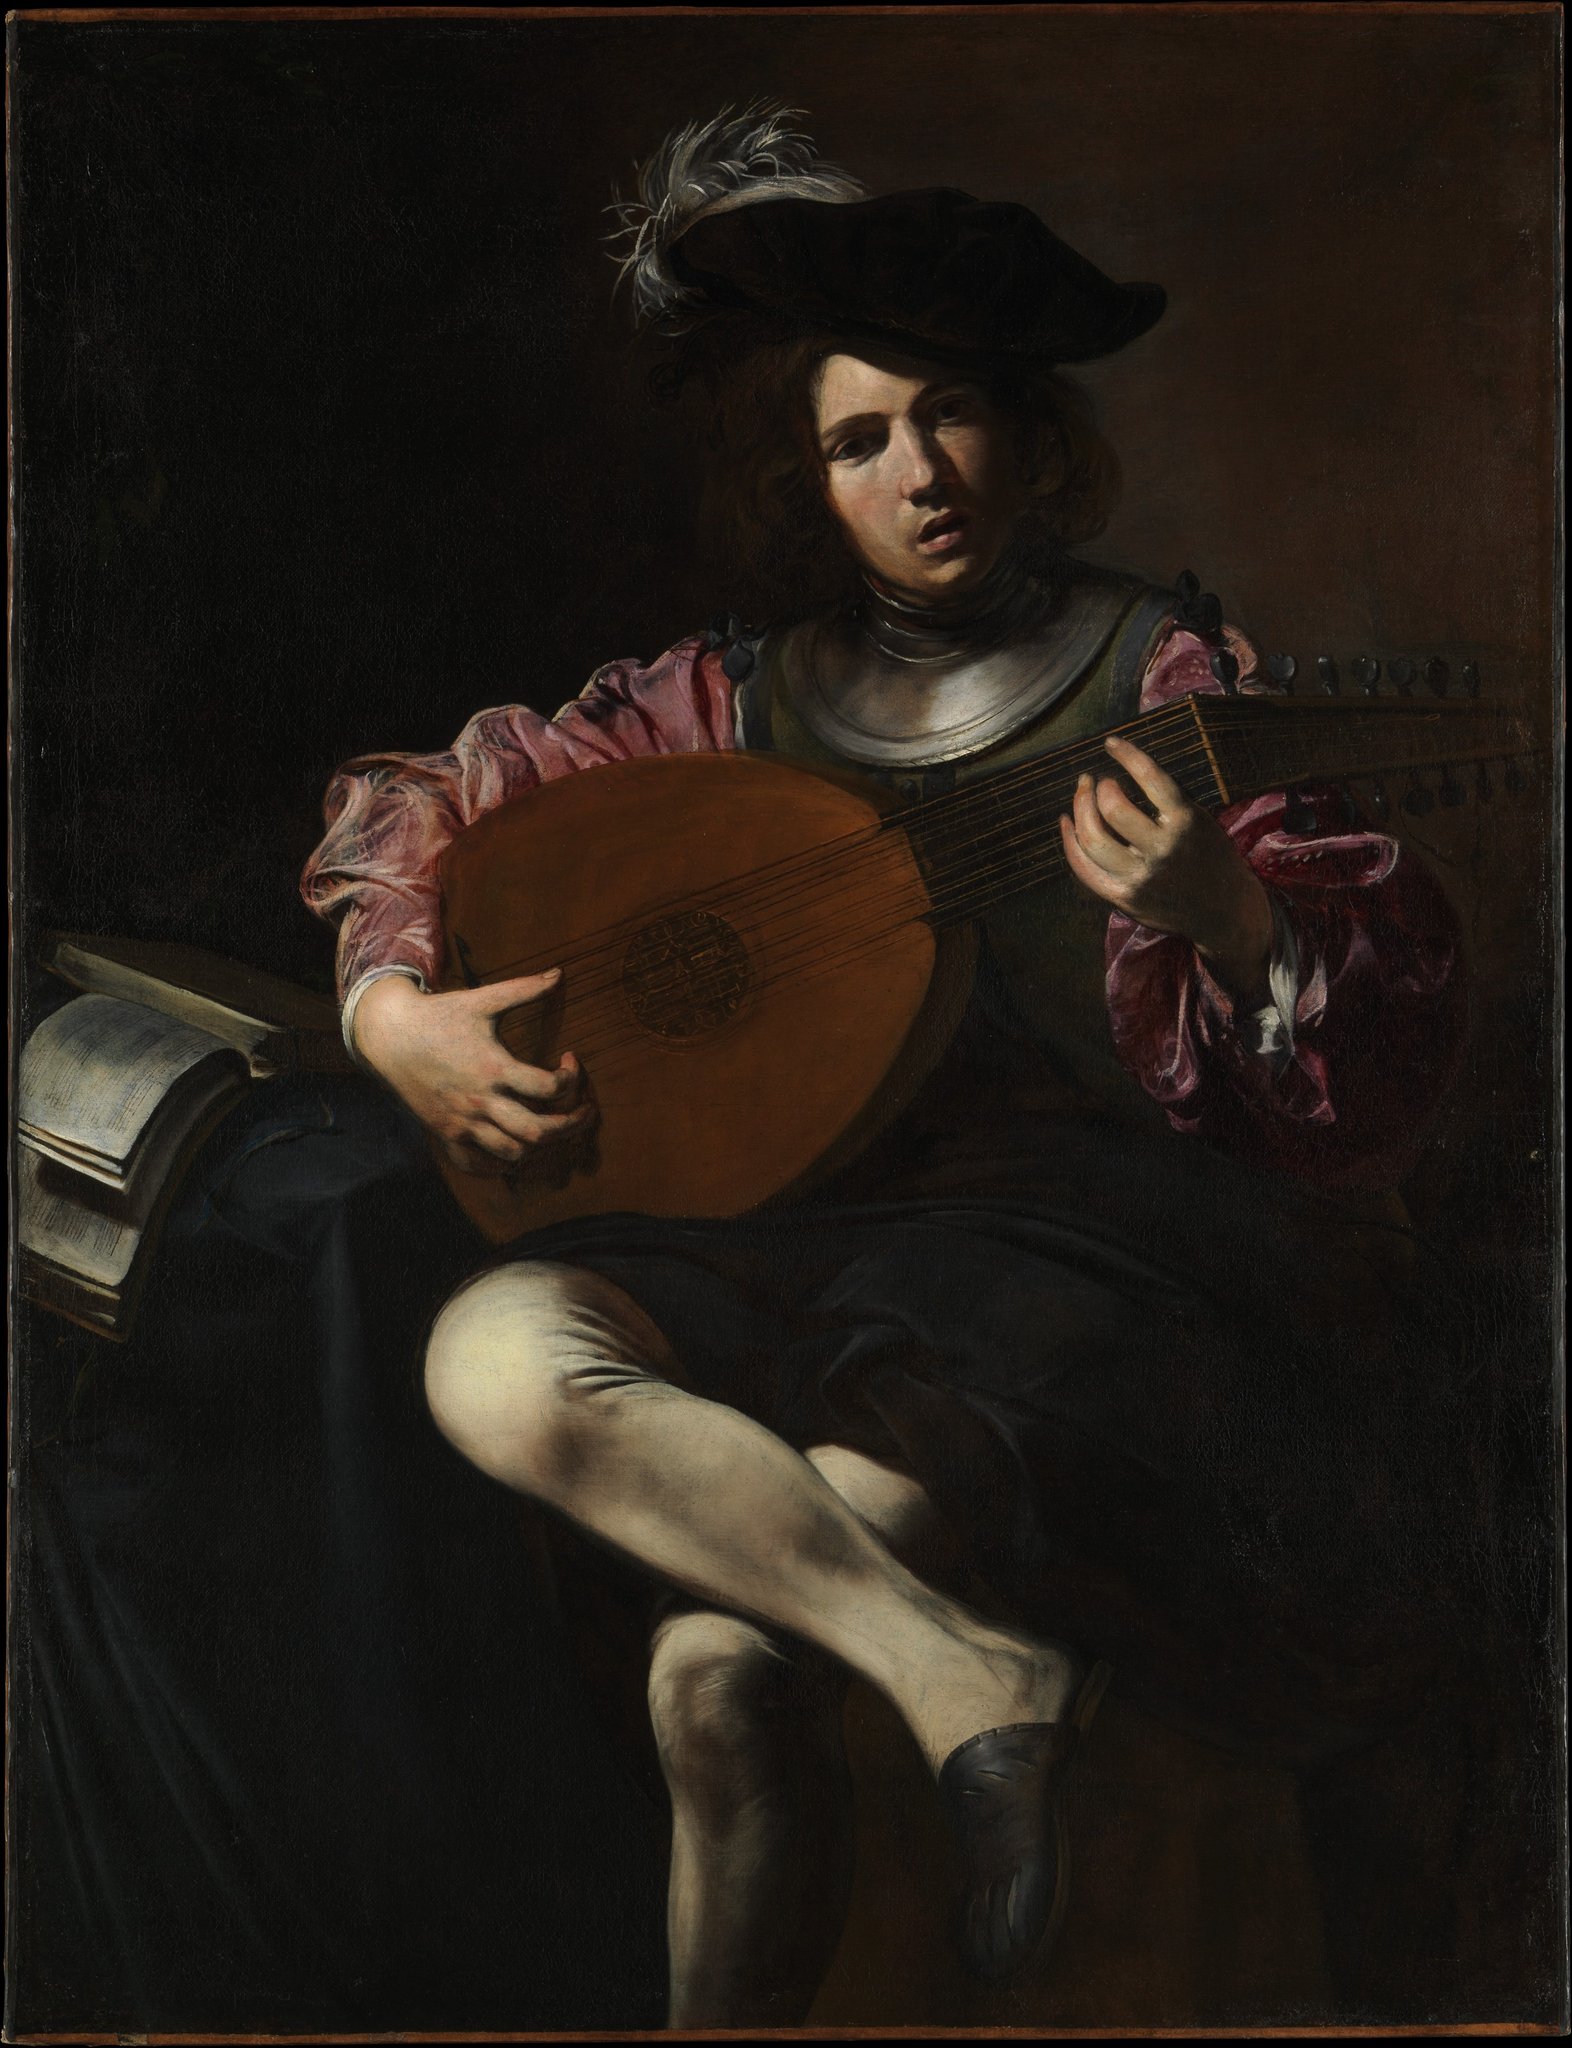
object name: painting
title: Lute Player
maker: valentin de boulogne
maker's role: artist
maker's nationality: french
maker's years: 1591-1632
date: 1625-1626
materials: canvas, oil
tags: men,lutes,musicians